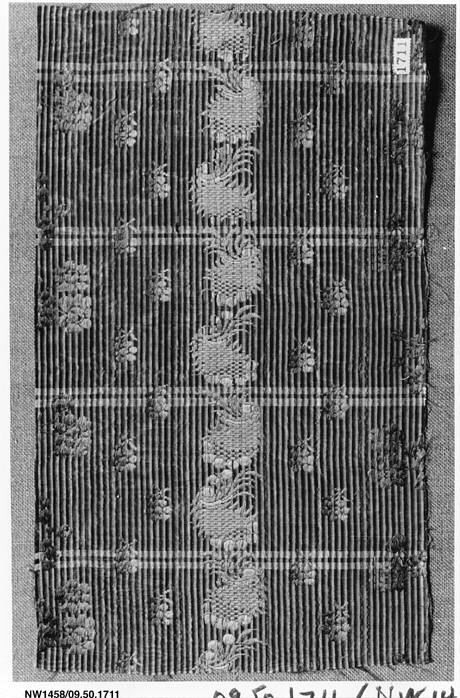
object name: piece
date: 1701-1800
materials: silk